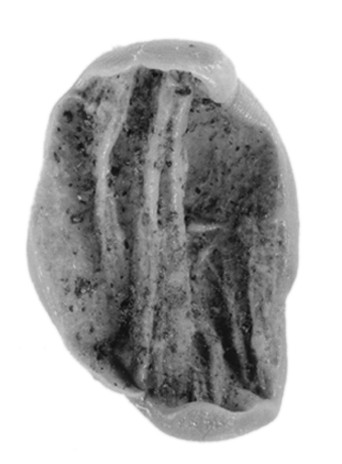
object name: sealing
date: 2030-1640 BCE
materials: clay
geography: egypt